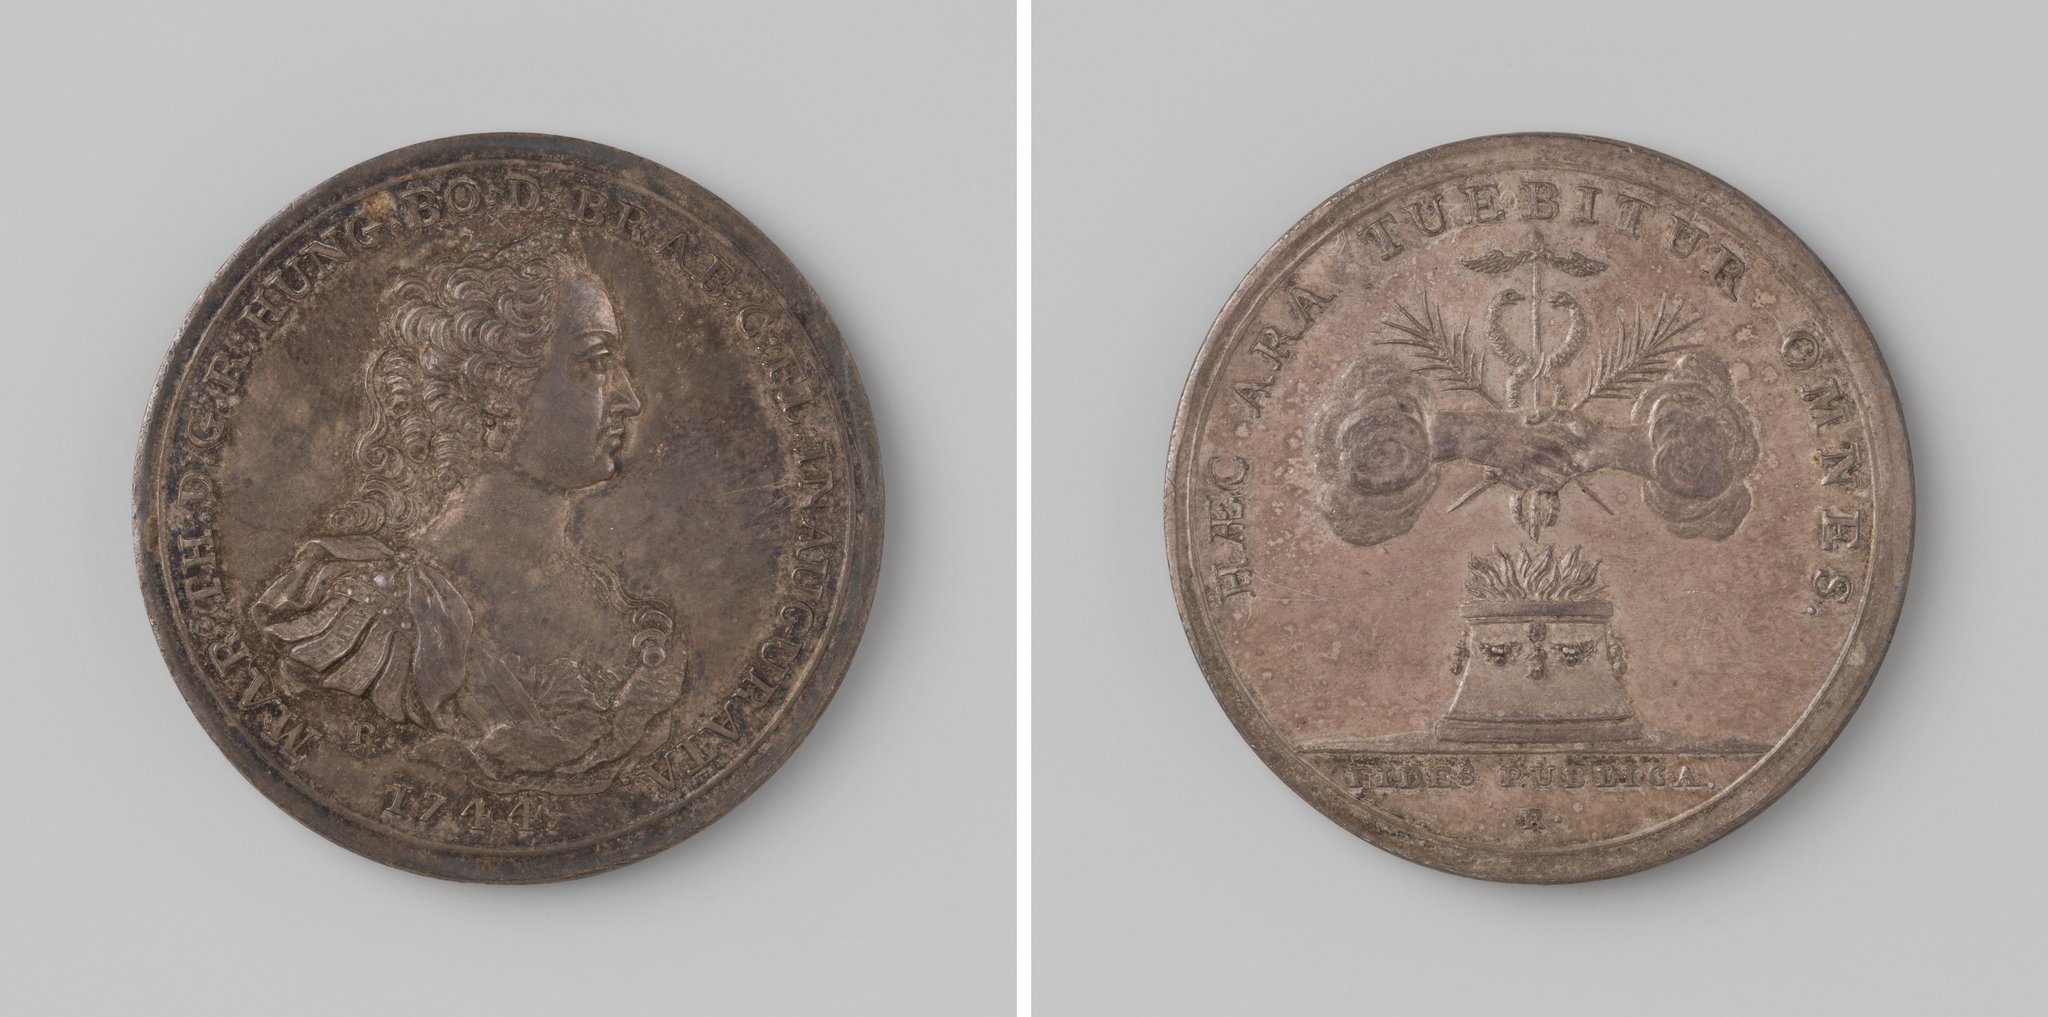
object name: history medal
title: Inhuldiging van Maria Theresia als gravin van Brabant en Vlaanderen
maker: jacques roëttiers (ii)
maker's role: medailleur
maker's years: 1698-1772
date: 1744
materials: silver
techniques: striking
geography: antwerp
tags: vienna, maria theresia (rooms-duits keizerin), brabant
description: Zilveren penning. Voorzijde: borststuk vrouw met diadeem binnen omschrift. Keerzijde: twee ineengeslagen handen uit wolken houden Mercuriusstaf en twee korenaren boven brandend altaar binnen omschrift; afsnede: opschrift